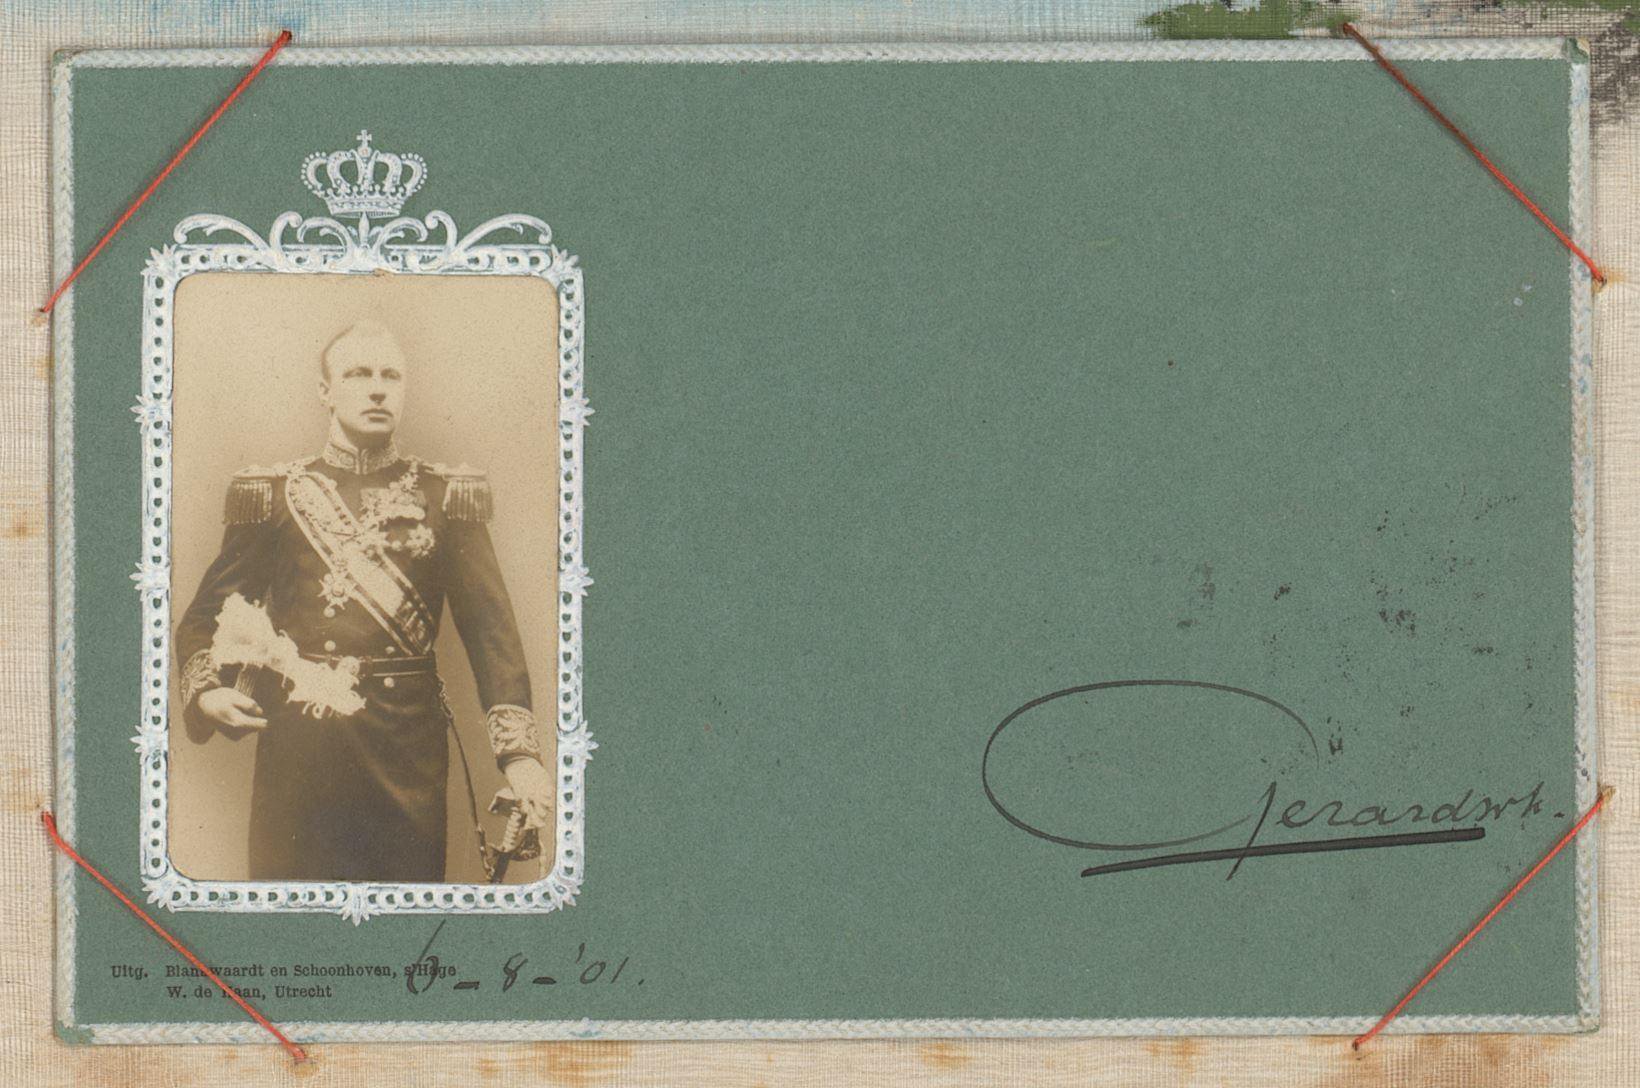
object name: photograph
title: Portret van koningin Hendrik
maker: Anonymous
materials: cardboard, paint, photographic support, silk, textile, watercolor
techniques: blind stamped, brush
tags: the hague, hendrik (prins der nederlanden (1876-1934)), historical persons, king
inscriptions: annotation: ‘6-8-'01 Gerard’